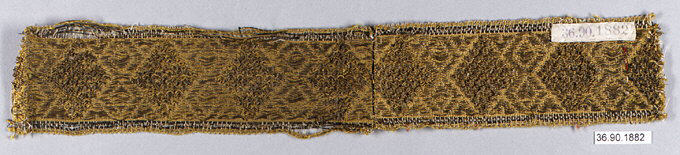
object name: galloon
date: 1801-1900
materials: silk